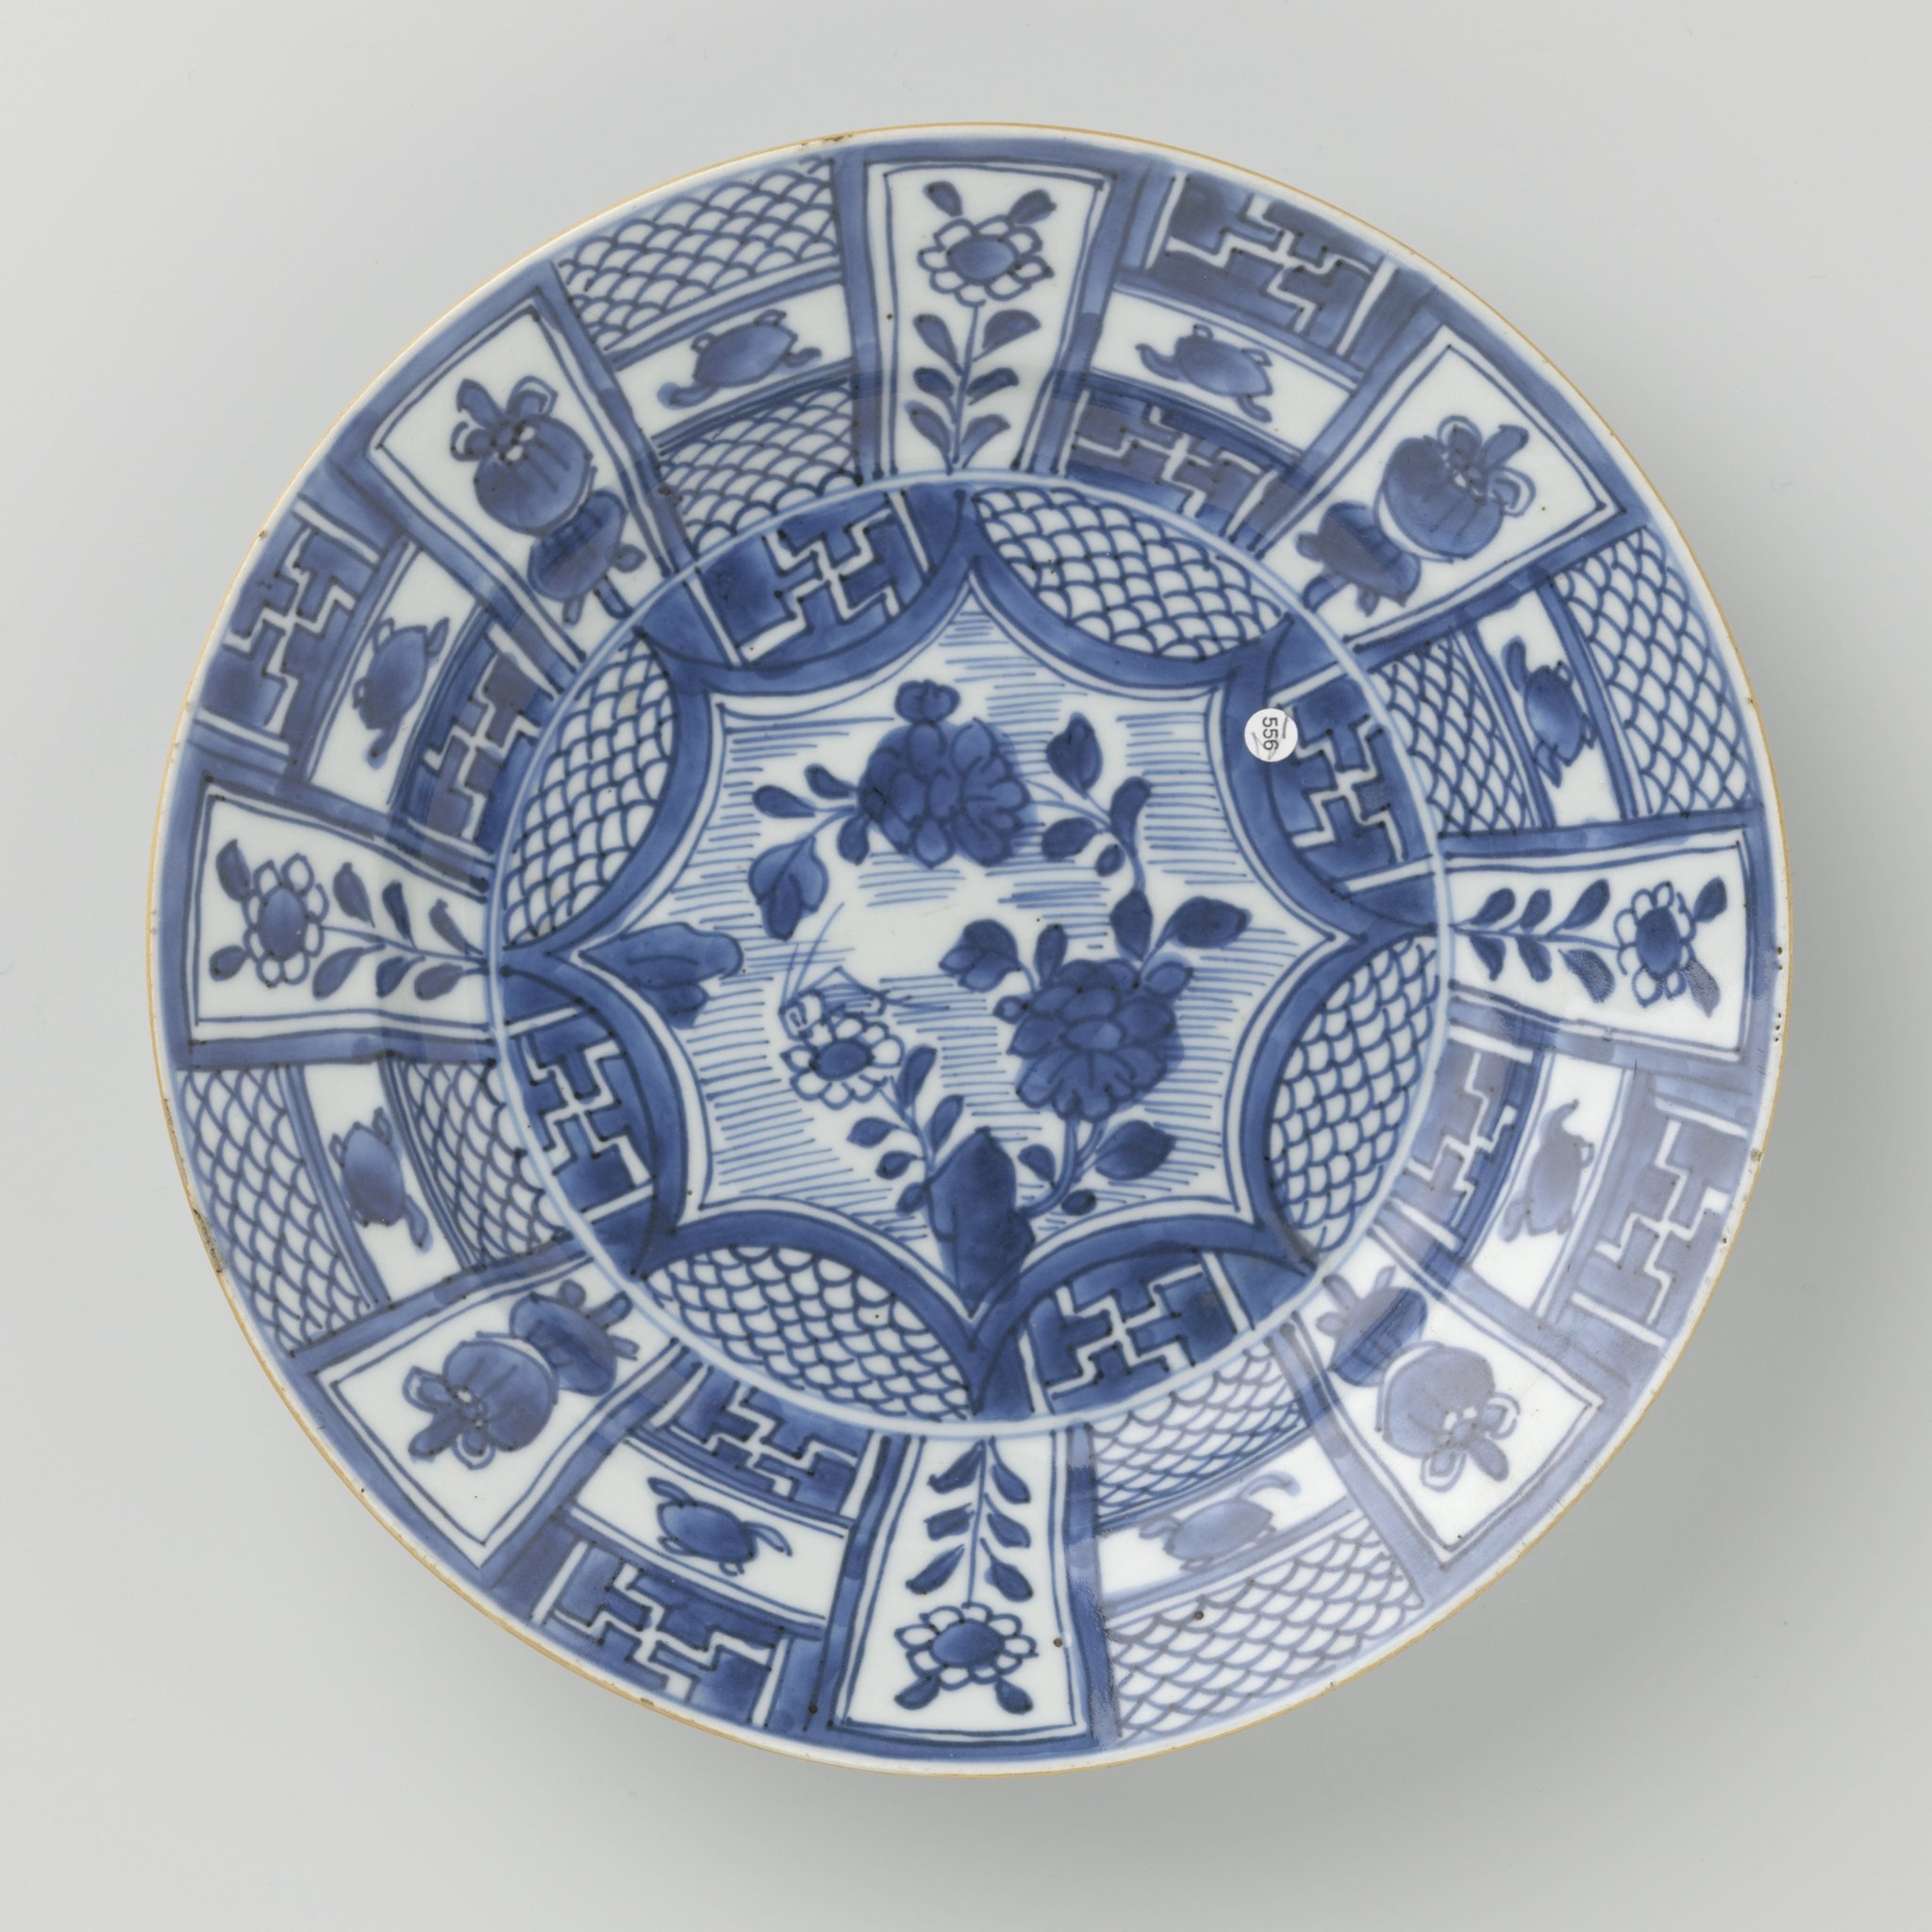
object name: plate dish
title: Plate with panel decoration with flower sprays and precious objects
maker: Anonymous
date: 1740-1760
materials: cobalt, glaze, paint, porcelain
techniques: firing, turning, vitrification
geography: china